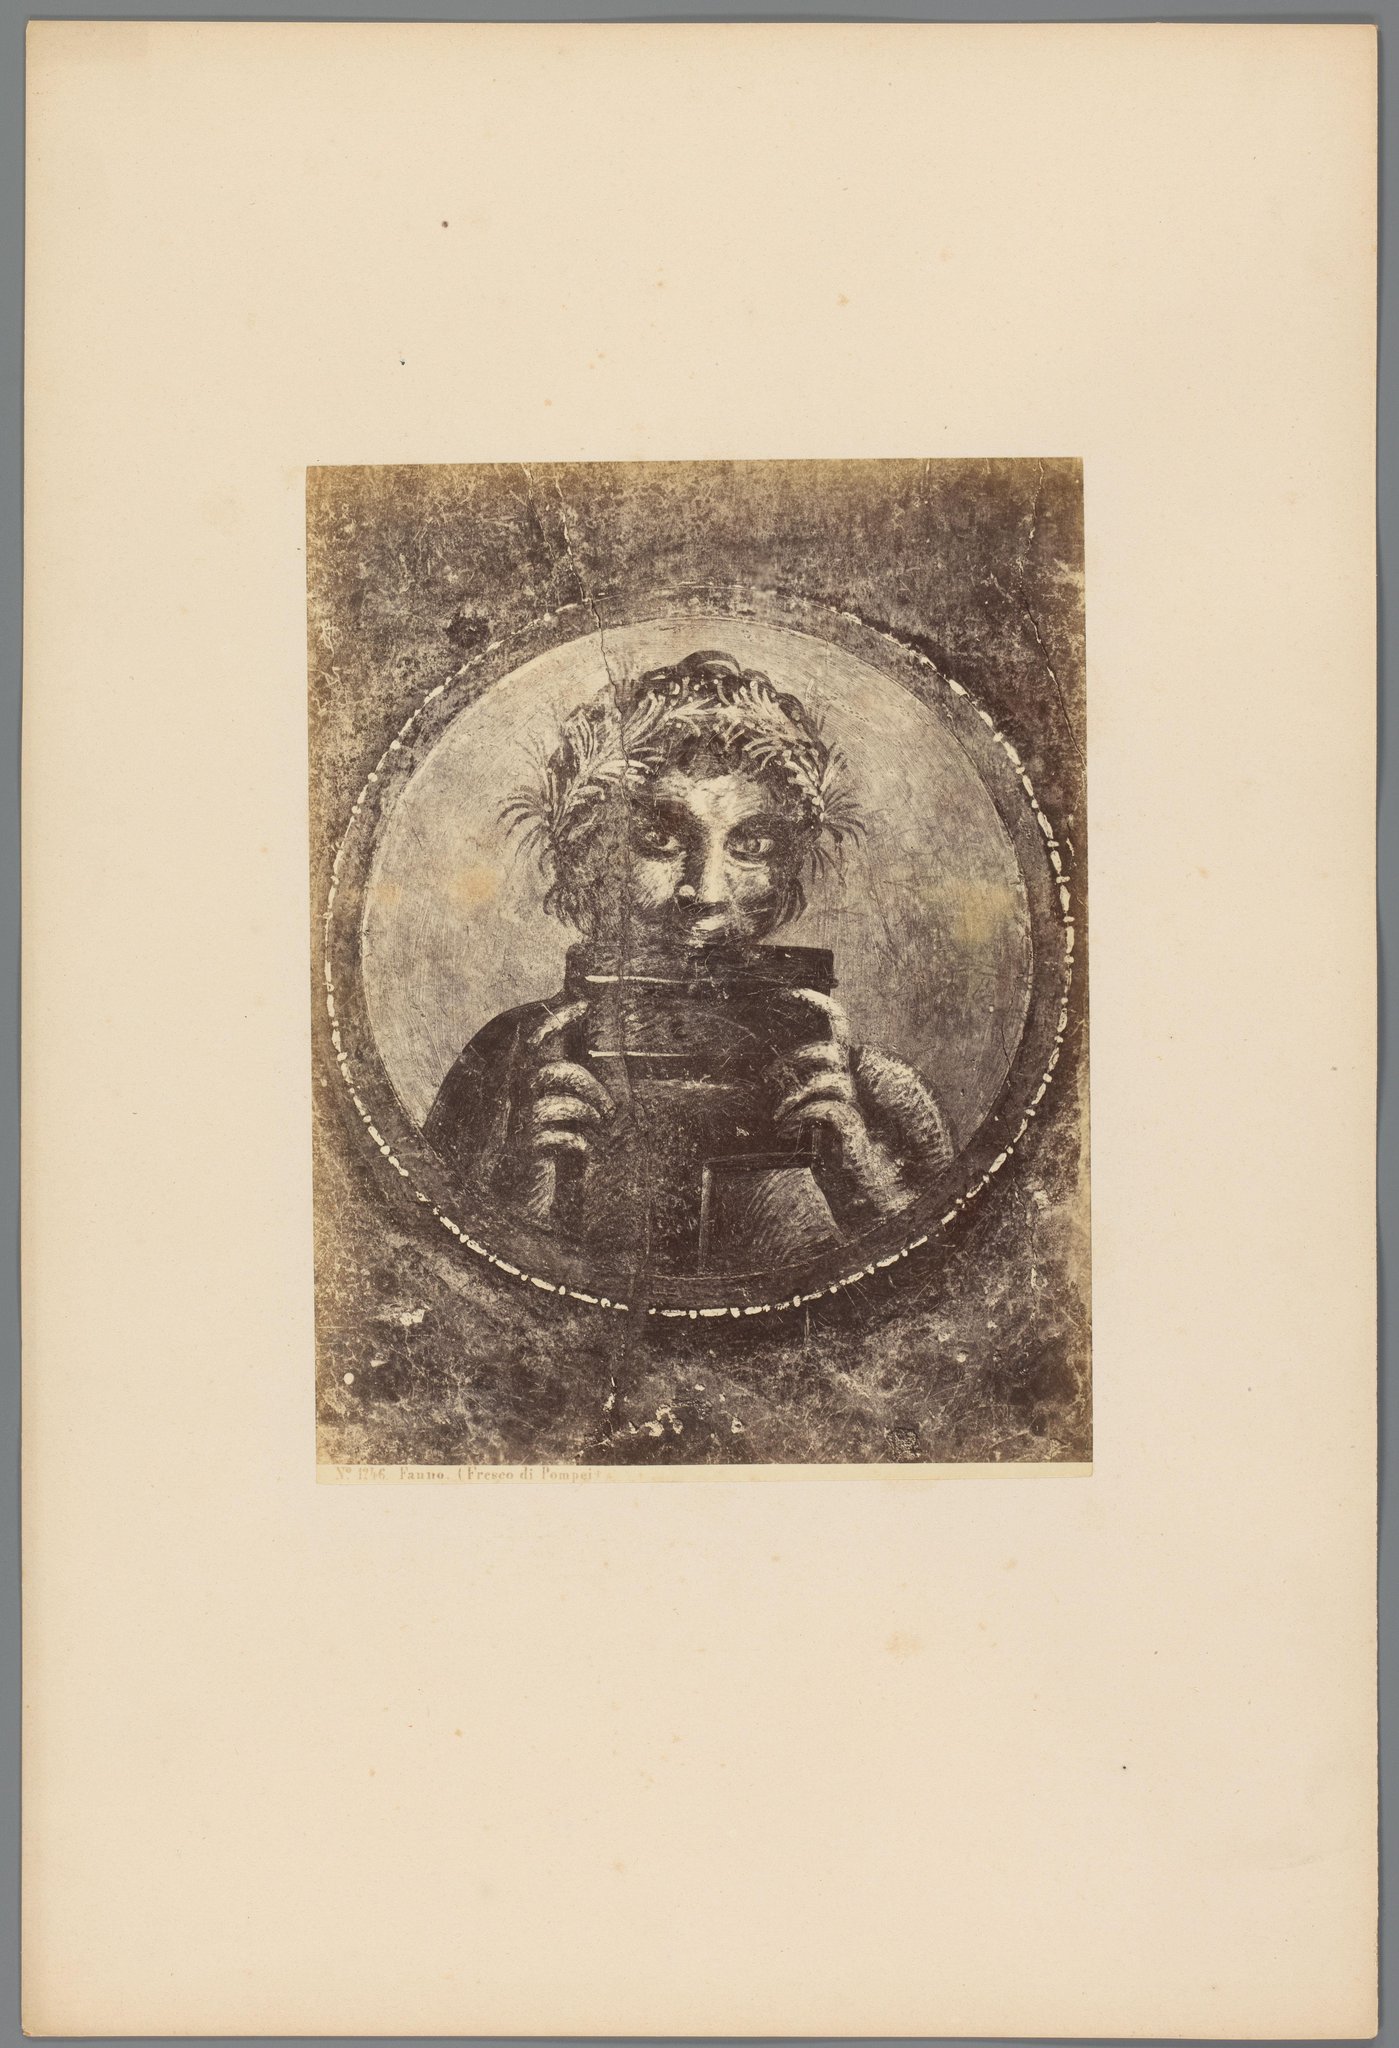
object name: reproduction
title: Fotoreproductie van een fresco voorstellende een faun te Pompeï, Italië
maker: Anonymous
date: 1851-1900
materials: cardboard, paper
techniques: albumen print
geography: pompeii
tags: satyrs, fauns, sileni, wall-covering, pompeii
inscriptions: number: ‘No. 1246.’